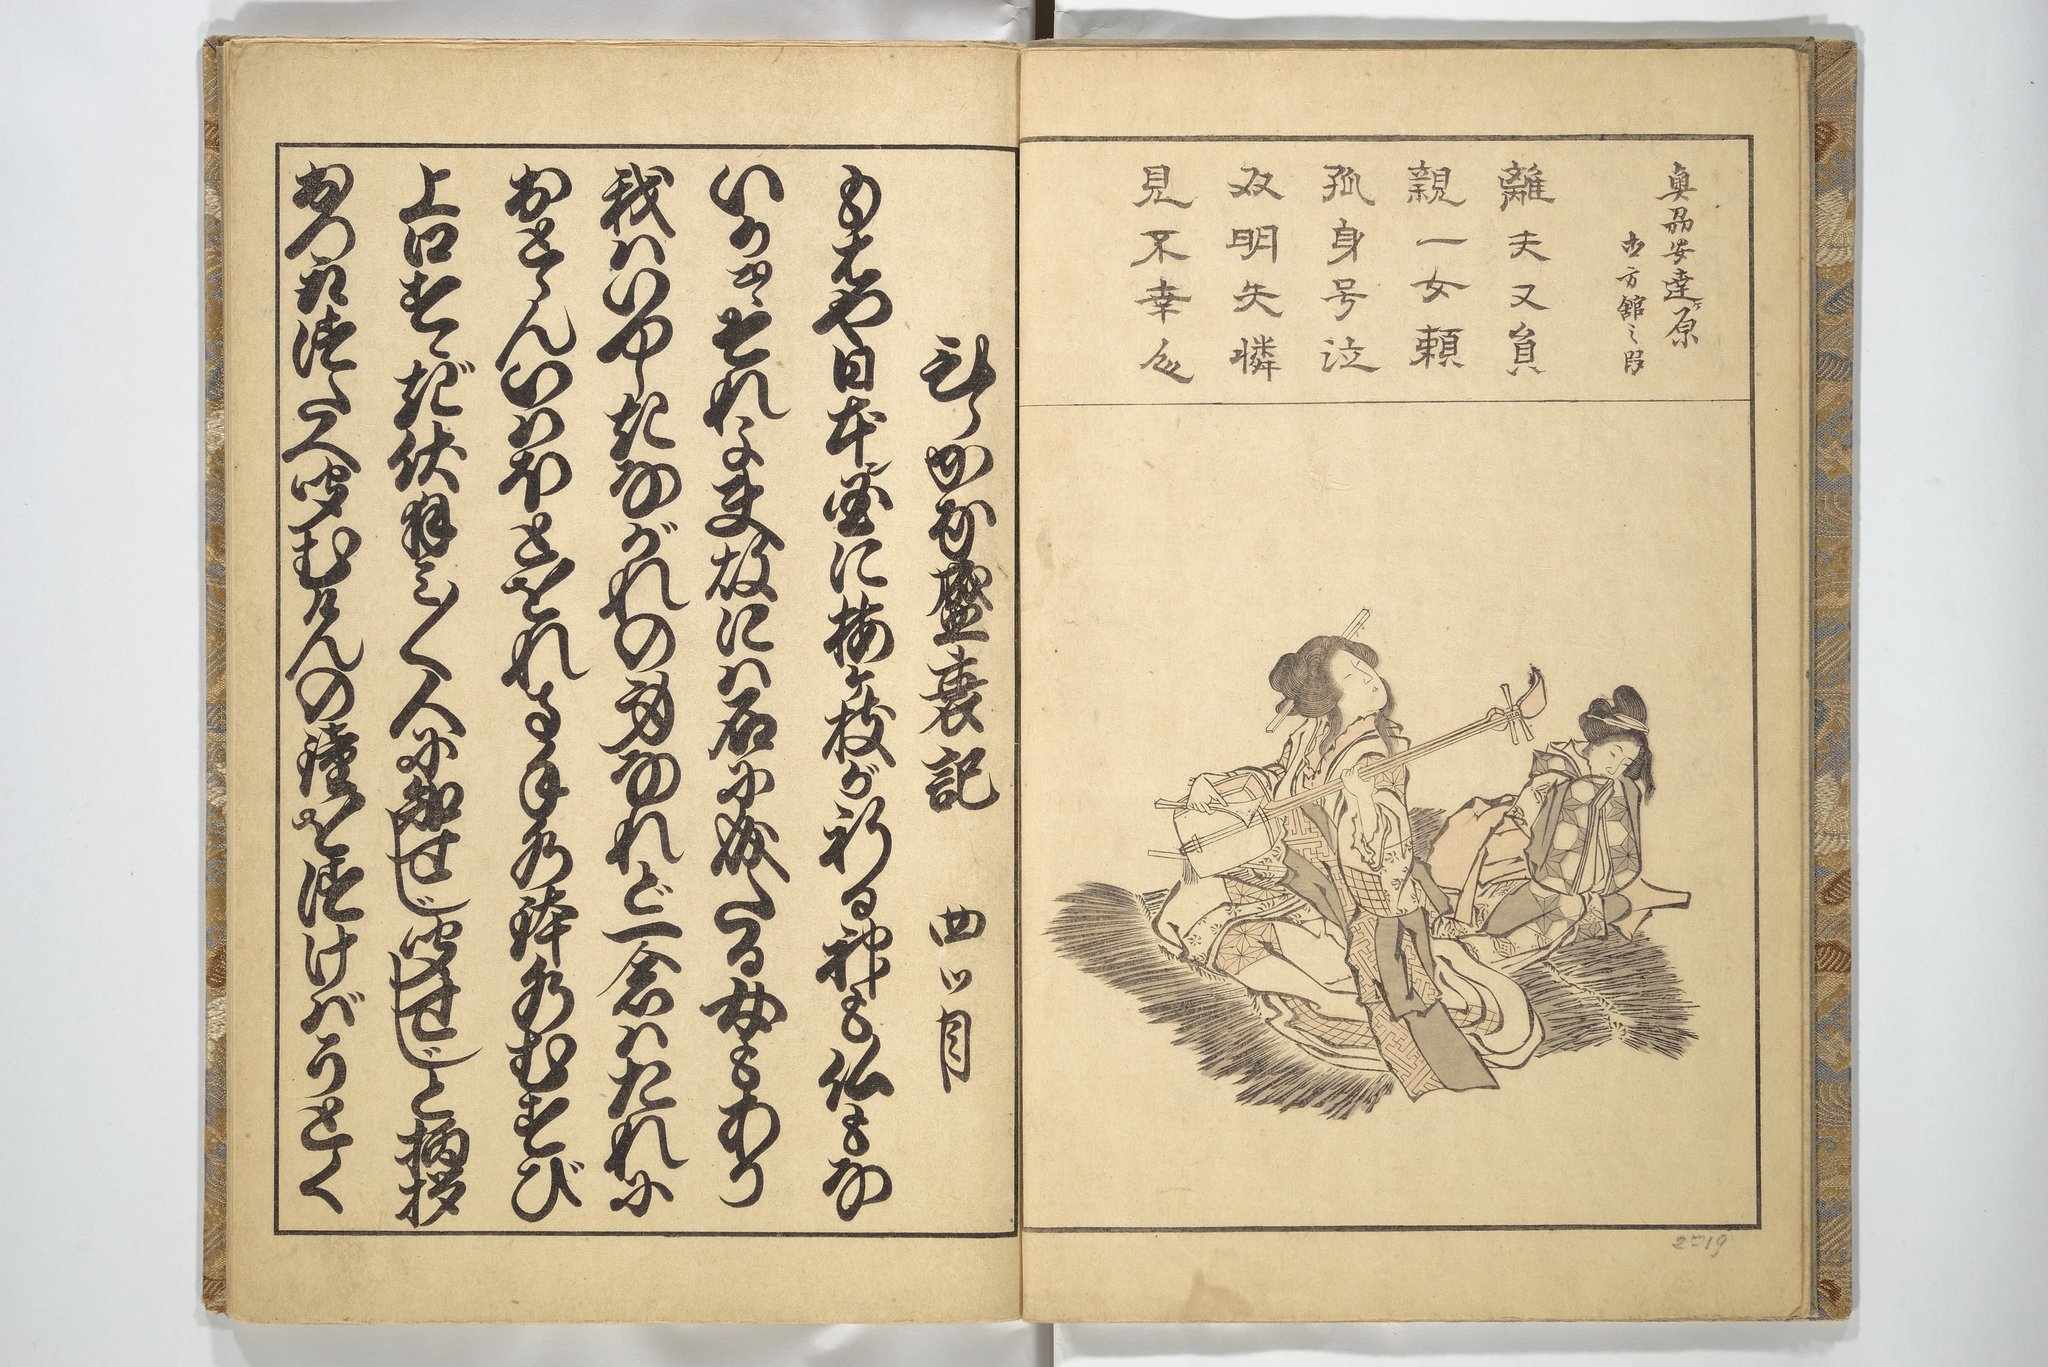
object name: illustrated book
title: Old Manji's Cursive Picture Album (Manjiō sōhitsu gafu) 卍翁艸筆画譜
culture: japanese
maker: katsushika hokusai 葛飾北斎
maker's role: artist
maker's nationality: japanese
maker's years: 1760-1849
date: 1843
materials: ink, paper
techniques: woodblock print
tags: musical instruments,women